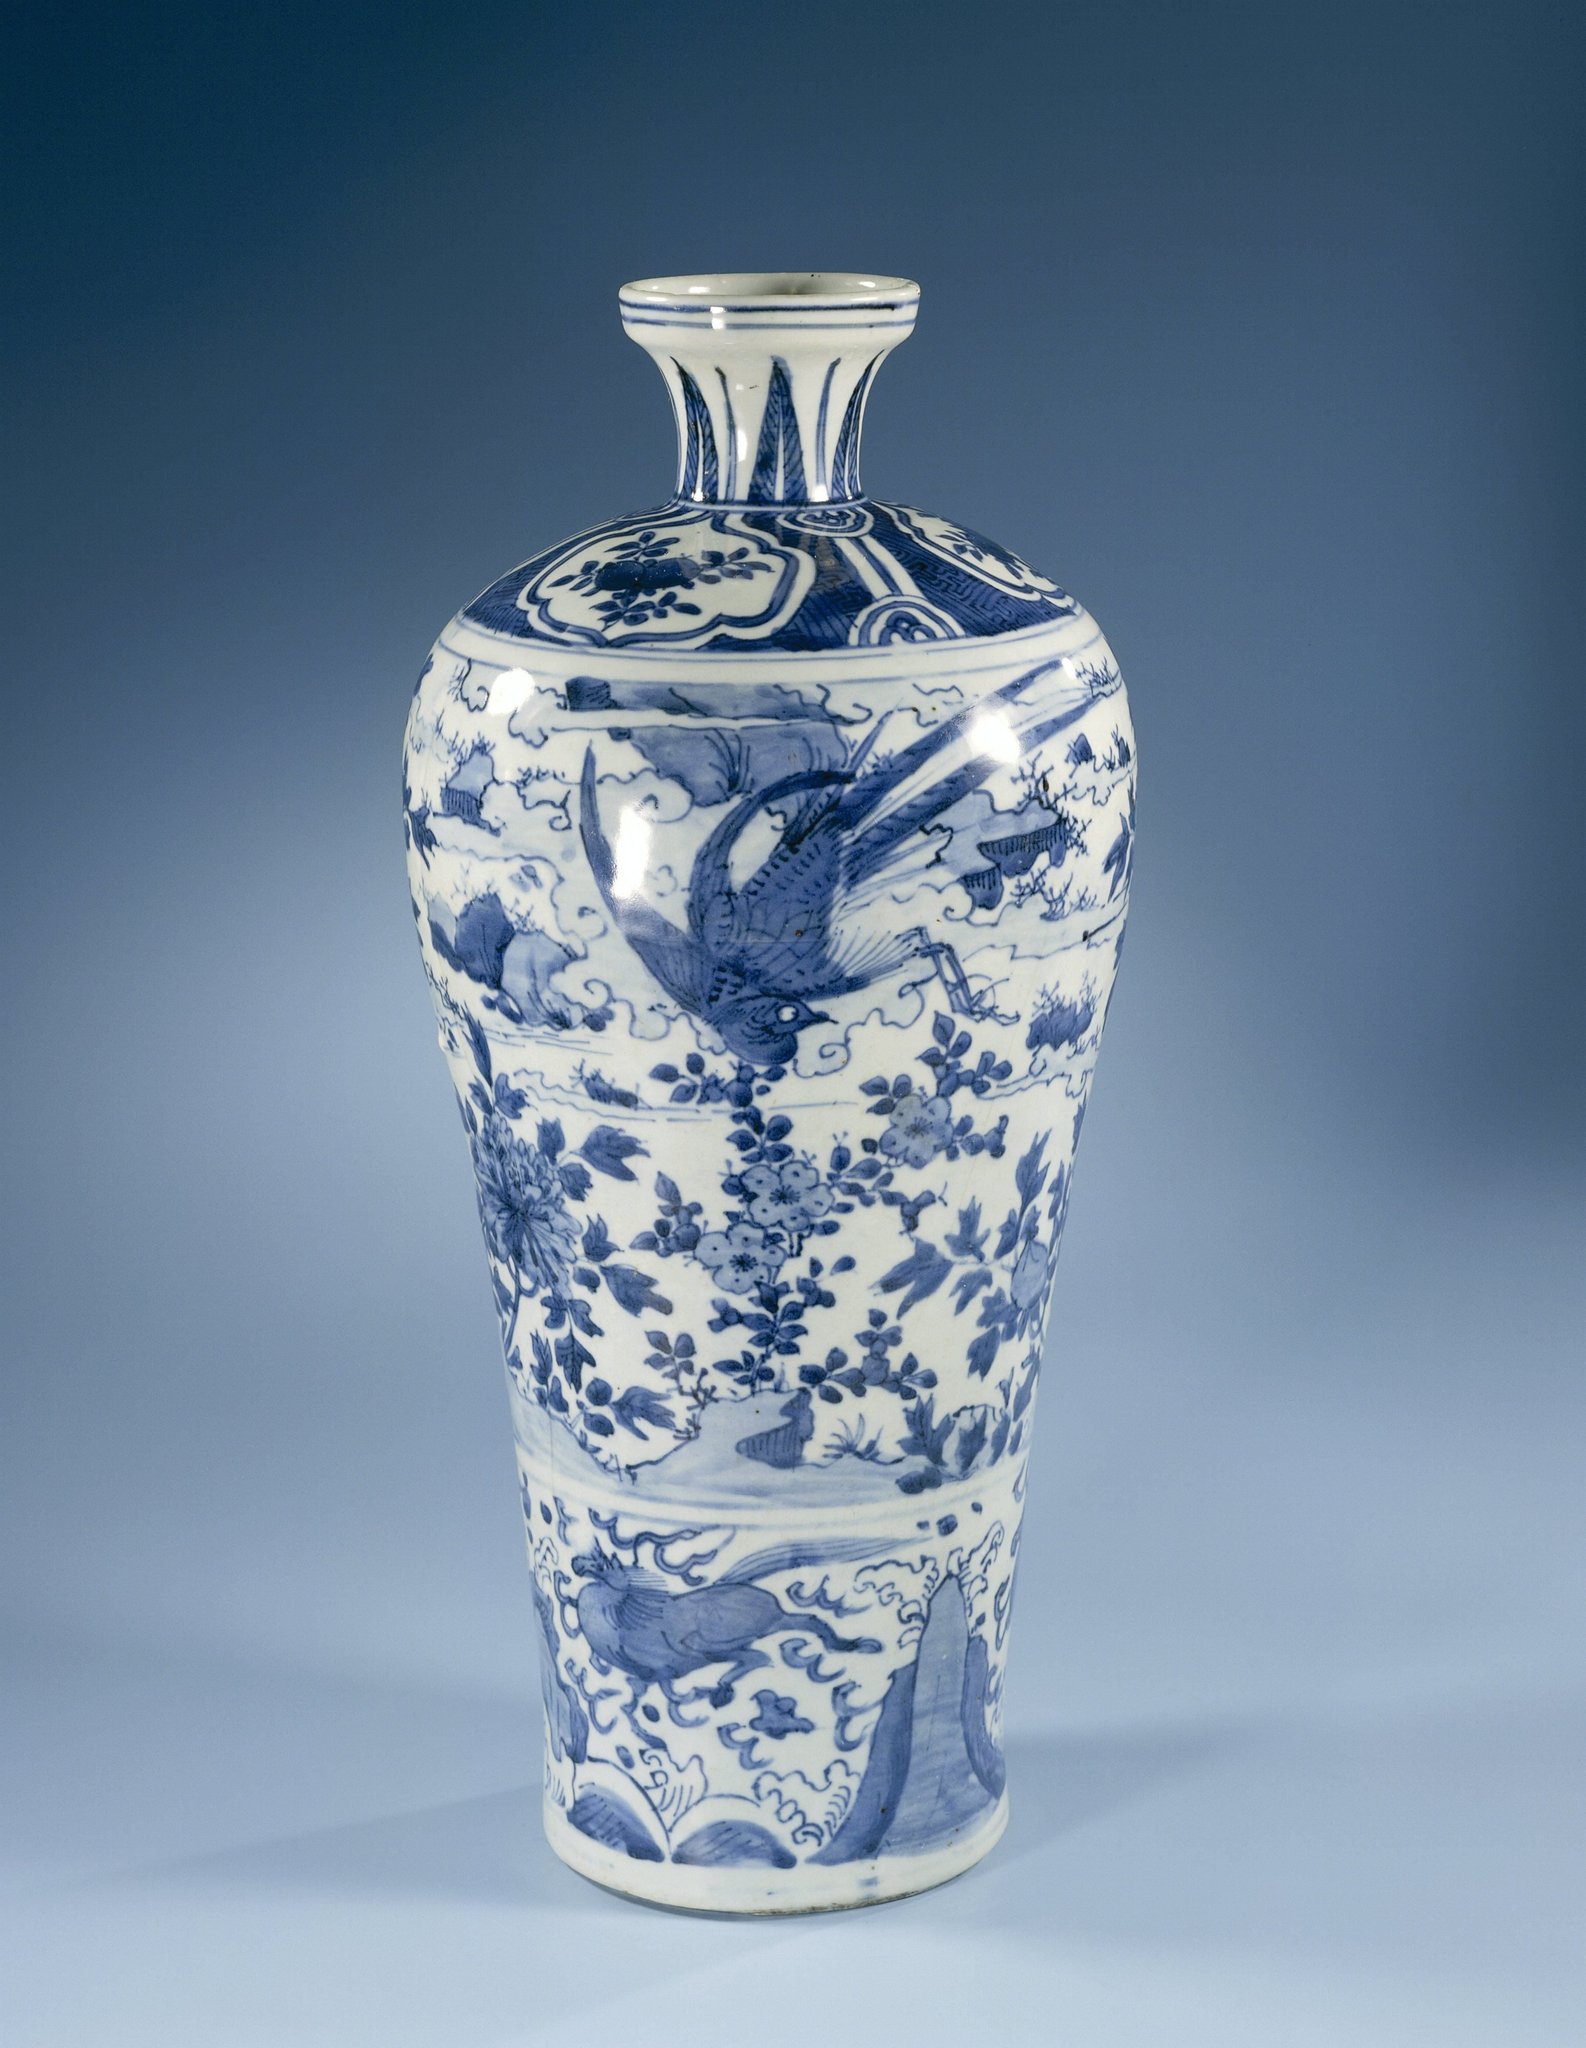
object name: vase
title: Vase with pheasants and horses in landscapes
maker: Anonymous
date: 1575-1599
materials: cobalt, glaze, paint, porcelain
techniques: firing, turning, vitrification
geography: china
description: Vaas van porselein met een naar boven toe uitlopend lichaam, ronde schouder en een smalle, spreidende nek met een opstaande rand, beschilderd in onderglazuur blauw. De buik is verdeeld in twee delen. Het bovenste deel met twee fazanten - één vliegend, de ander op een rots - in een landschap met bloeiende planten (pioen, prunus) en wolken. Aan de onderkant twee paarden omgeven door vlammen, rennend boven kolkende golven en rotsen. Op de schouder drie vakken met een swastikapatroon onderbroken door een cartouche met perziktakken; de vakken zijn gescheiden door een ruyi-motief. Op de nek een band met puntige bladmotieven. Een barst in de rand en één in de buik. Ming porselein in blauw-wit.